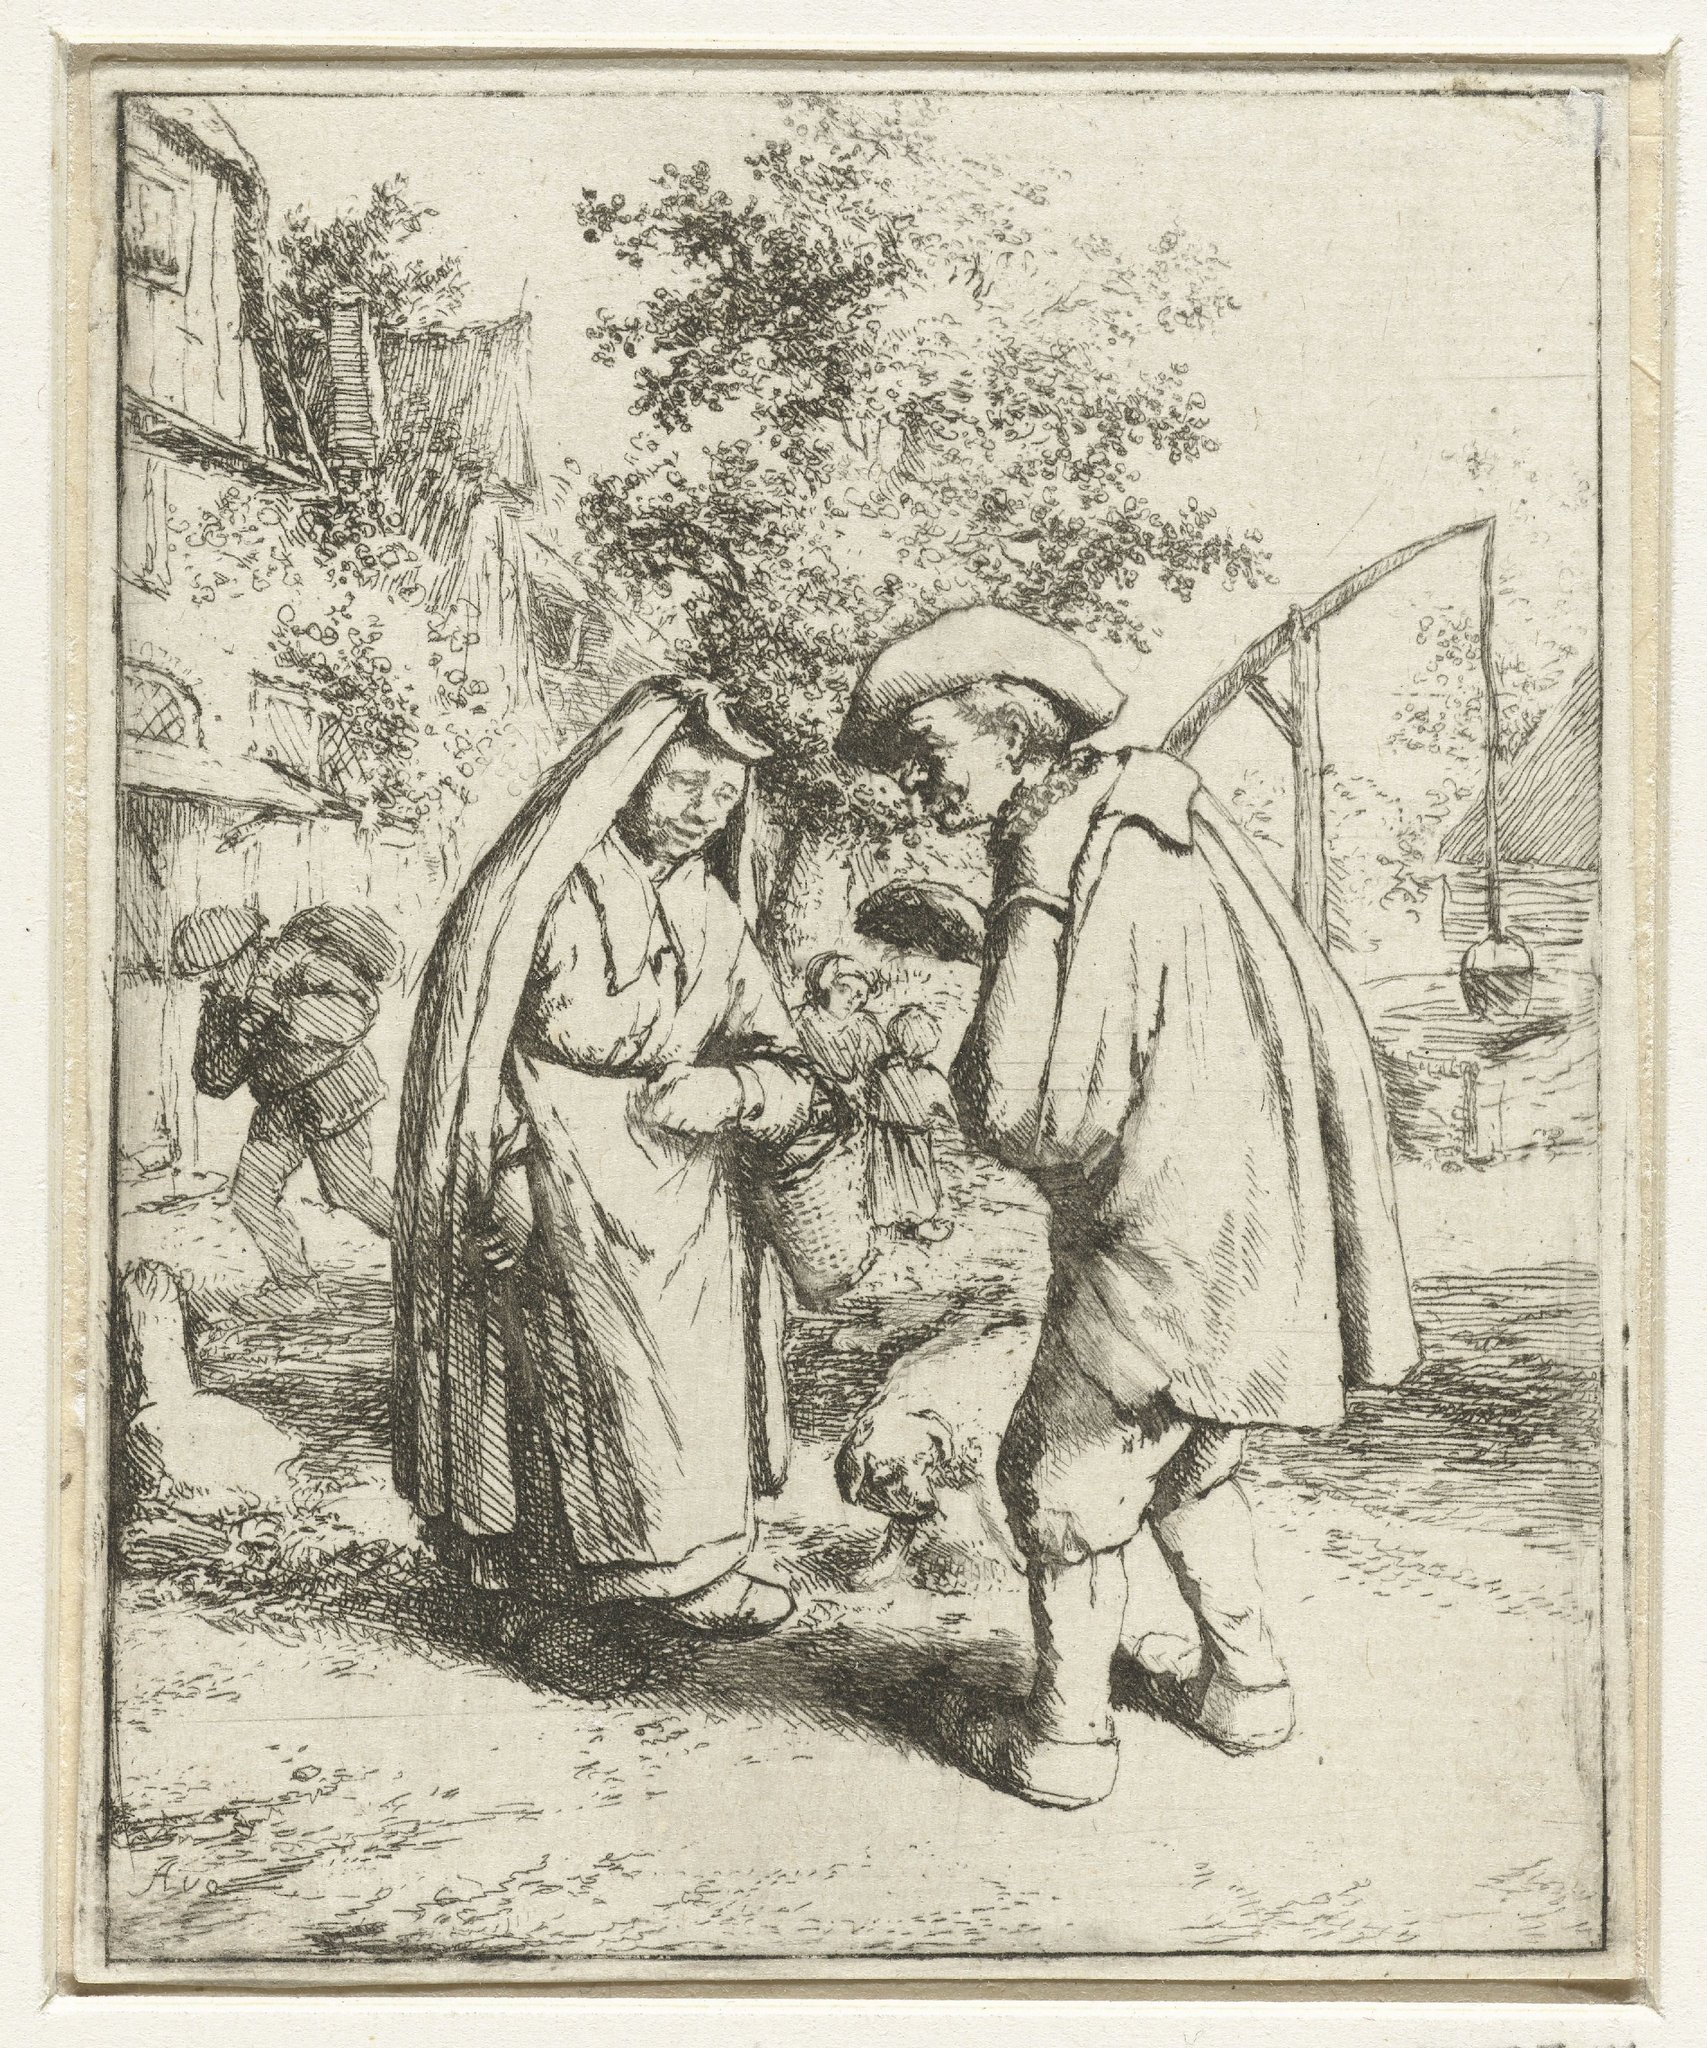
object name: print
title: Het gesprek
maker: adriaen van ostade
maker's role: draughtsman, painter, print maker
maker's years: 1610-1685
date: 1646-1650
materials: paper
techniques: etching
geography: haarlem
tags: female sex; woman, conversation, dialogue; conversation piece, male sex; man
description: Een man en vrouw zijn met elkaar in gesprek in een dorp. De vrouw draagt over haar boerenkleding een huikje.